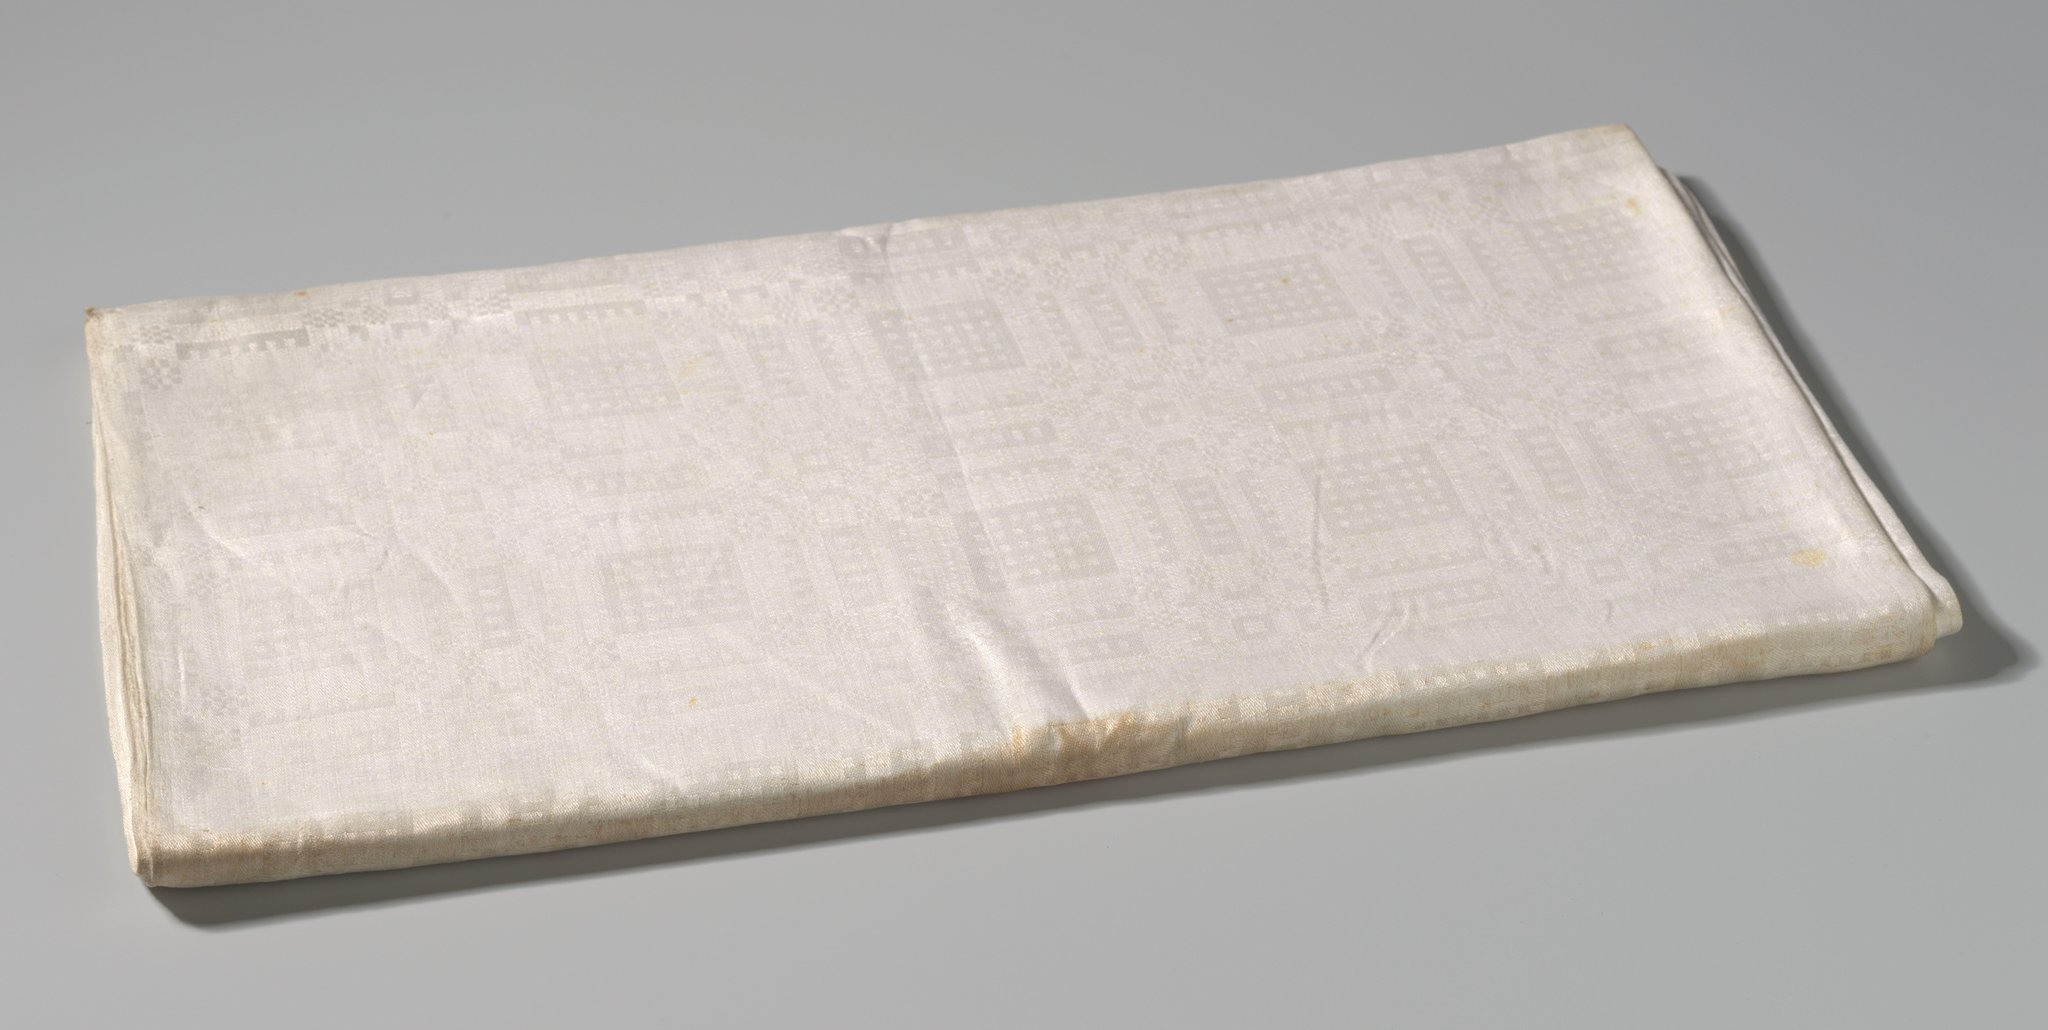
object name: tablecloth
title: Tafellaken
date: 1756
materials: linen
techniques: peeled fabric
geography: northern netherlands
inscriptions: date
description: Wit linnen tafellaken met een pellen patroon. Merk kroon G 2 en 1756.